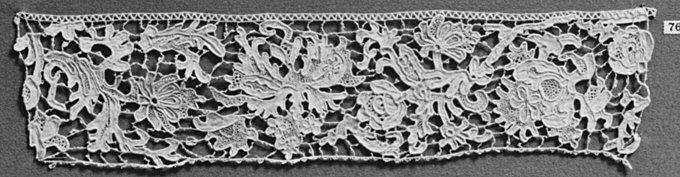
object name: border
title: Border (one of two)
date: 1801-1900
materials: lace, linen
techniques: gros point, lace